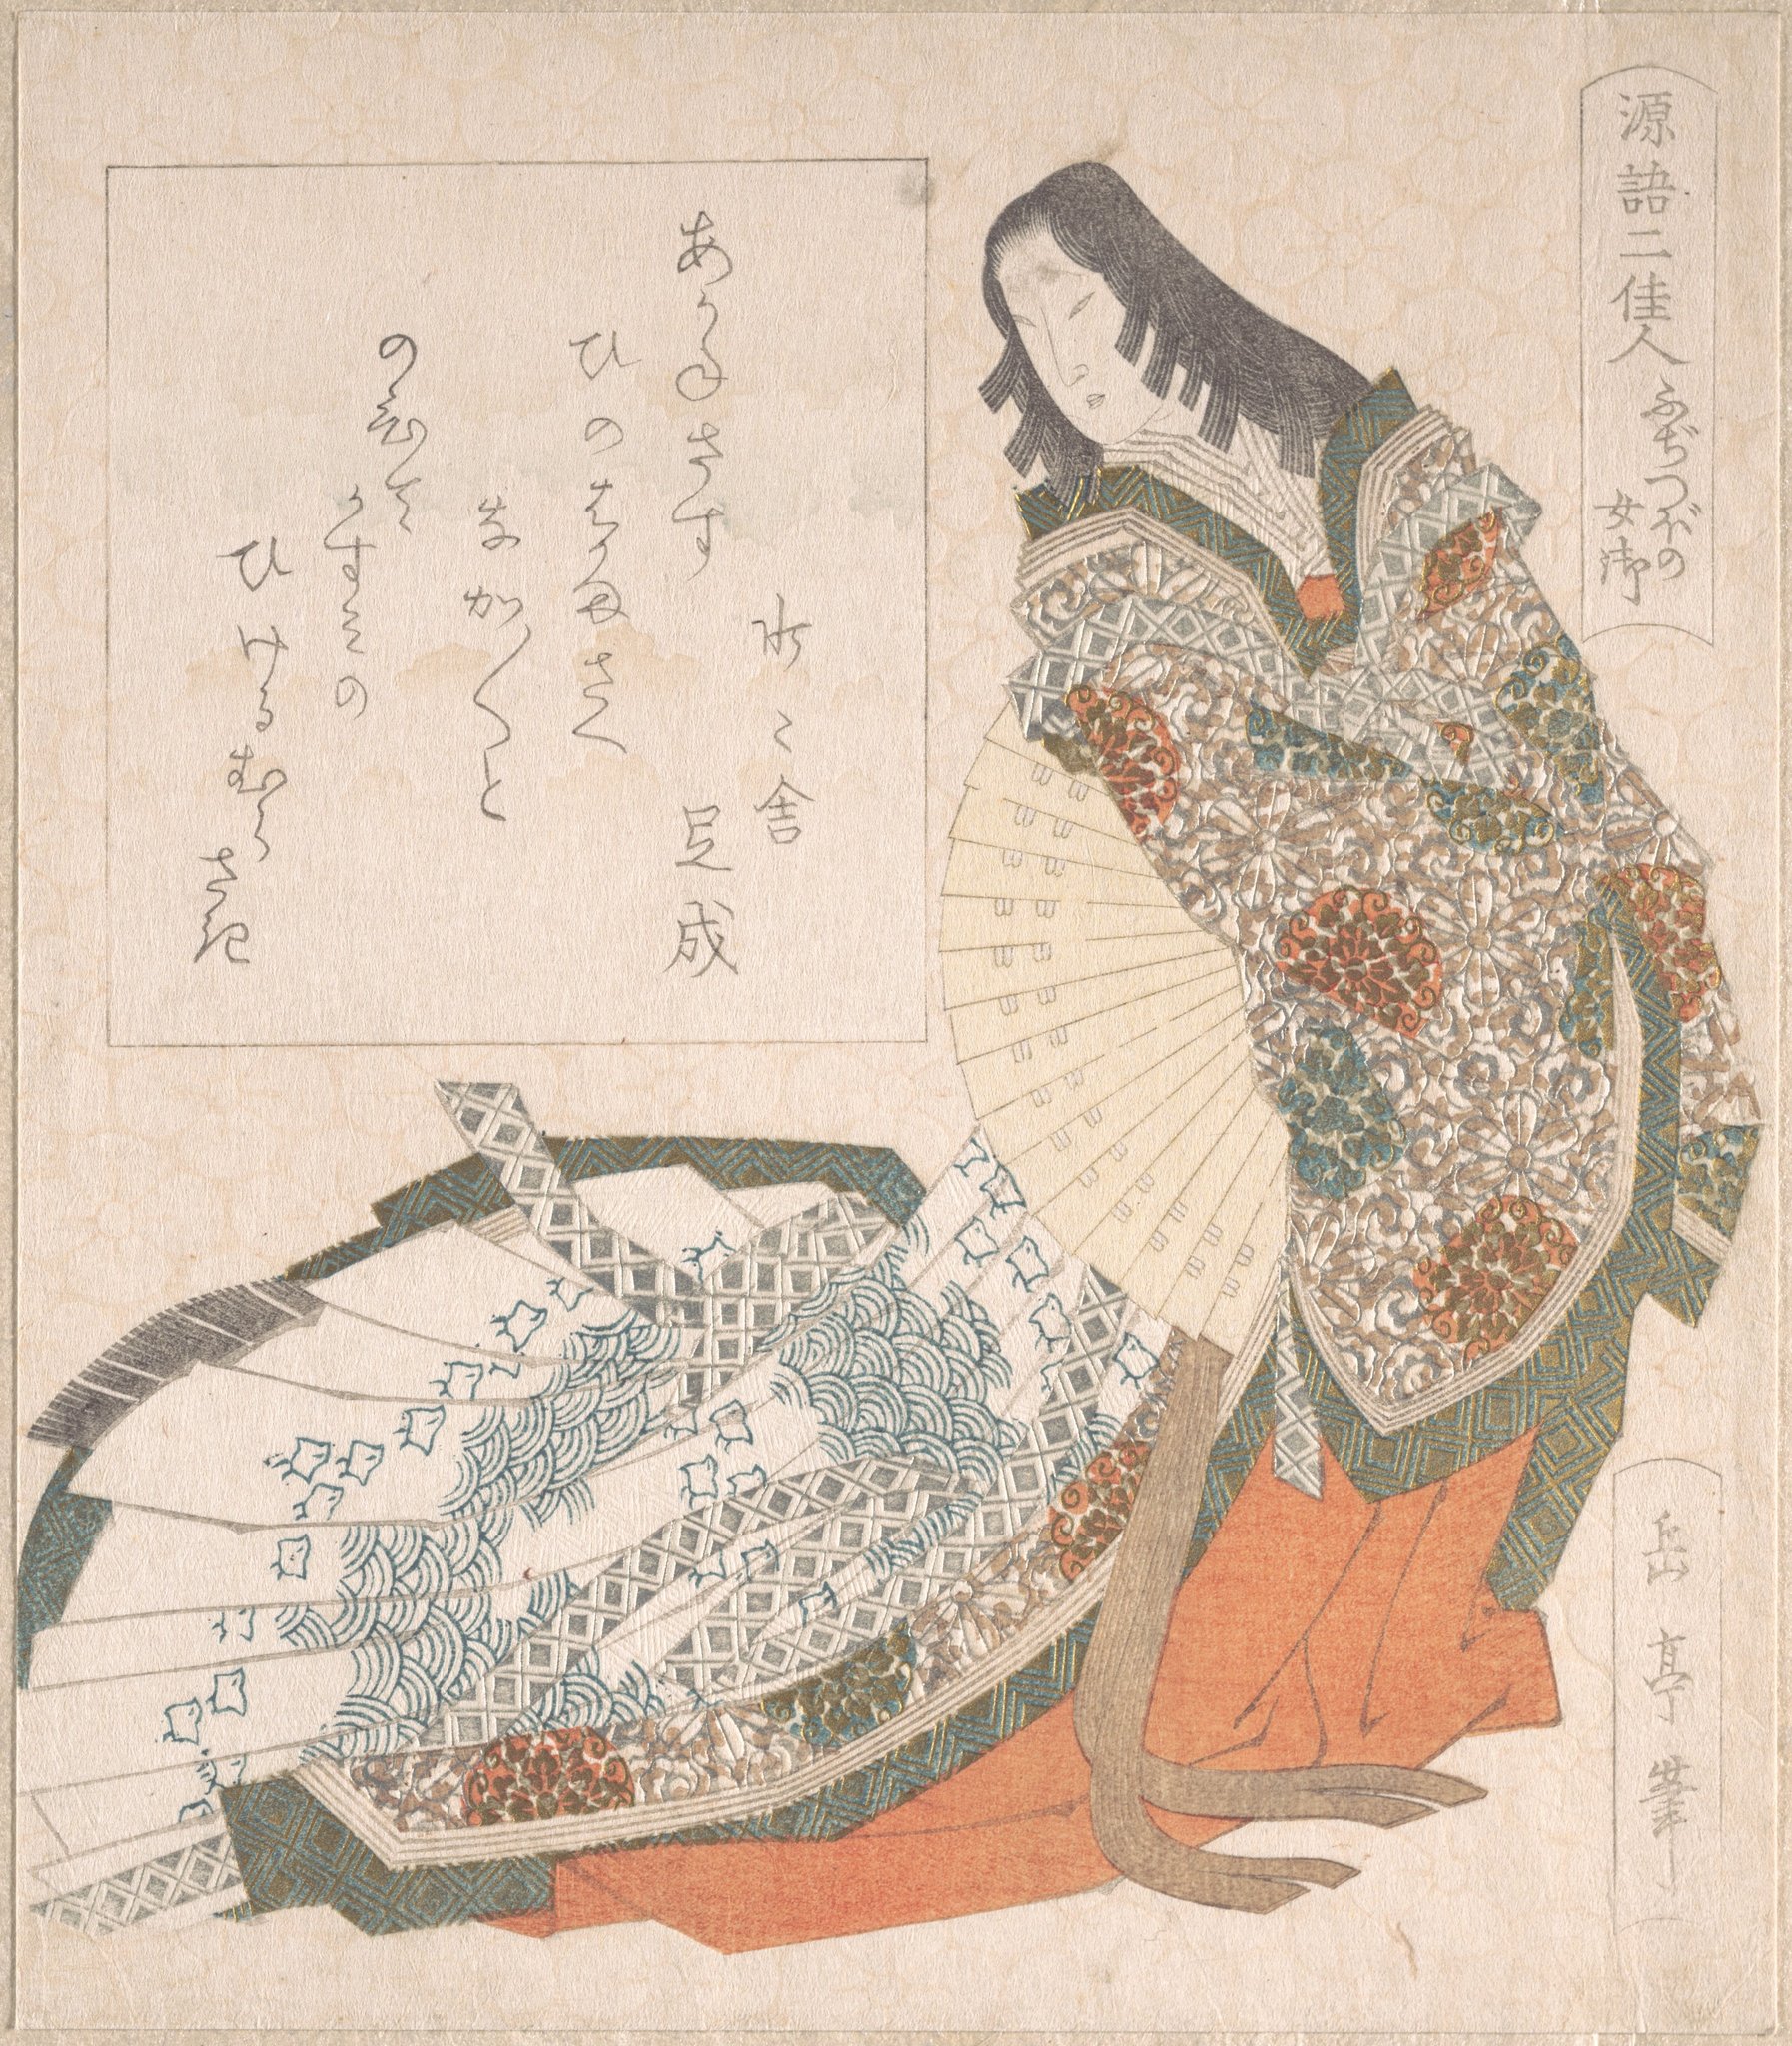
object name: print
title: Princess Fujitsubo in Court Costume with a Fan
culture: japanese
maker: yashima gakutei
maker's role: artist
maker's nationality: japanese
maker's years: 1786-1868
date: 1801-1900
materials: ink, paper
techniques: surimono, woodblock print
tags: fans,women